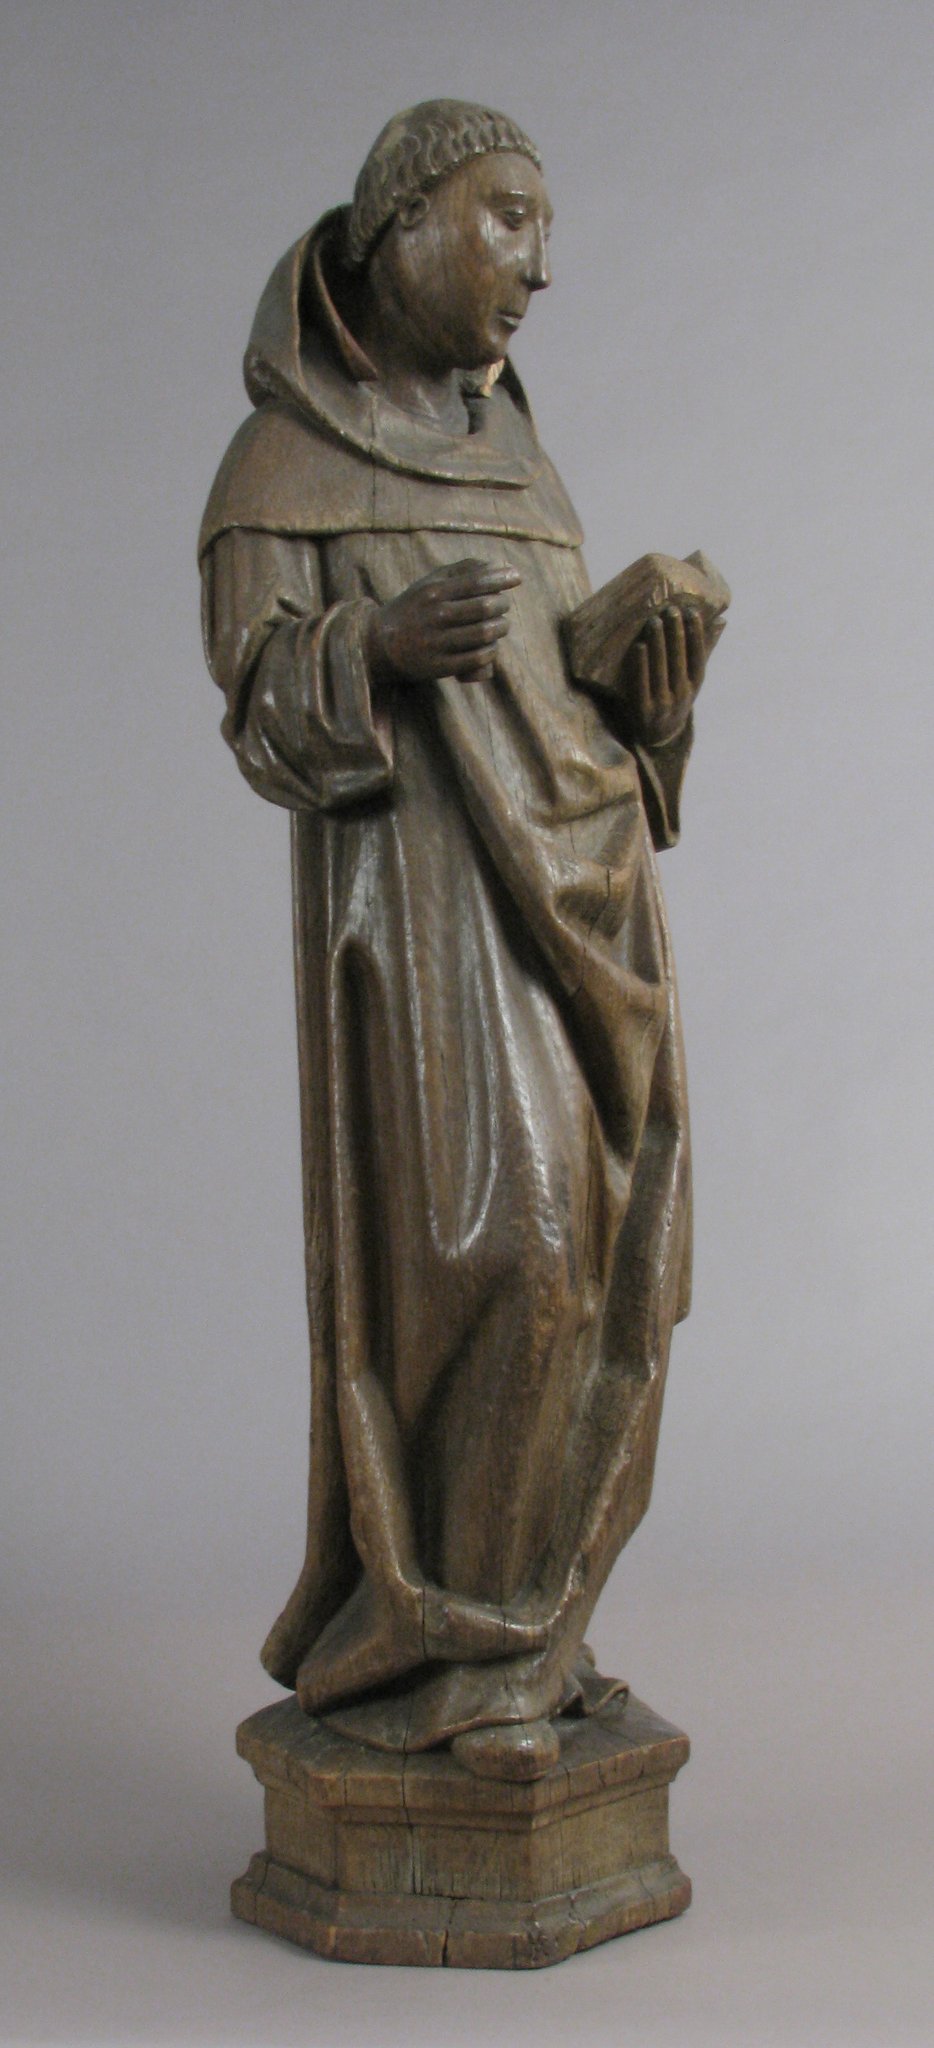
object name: statue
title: Monastic Saint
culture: dutch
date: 1480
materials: wood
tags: men